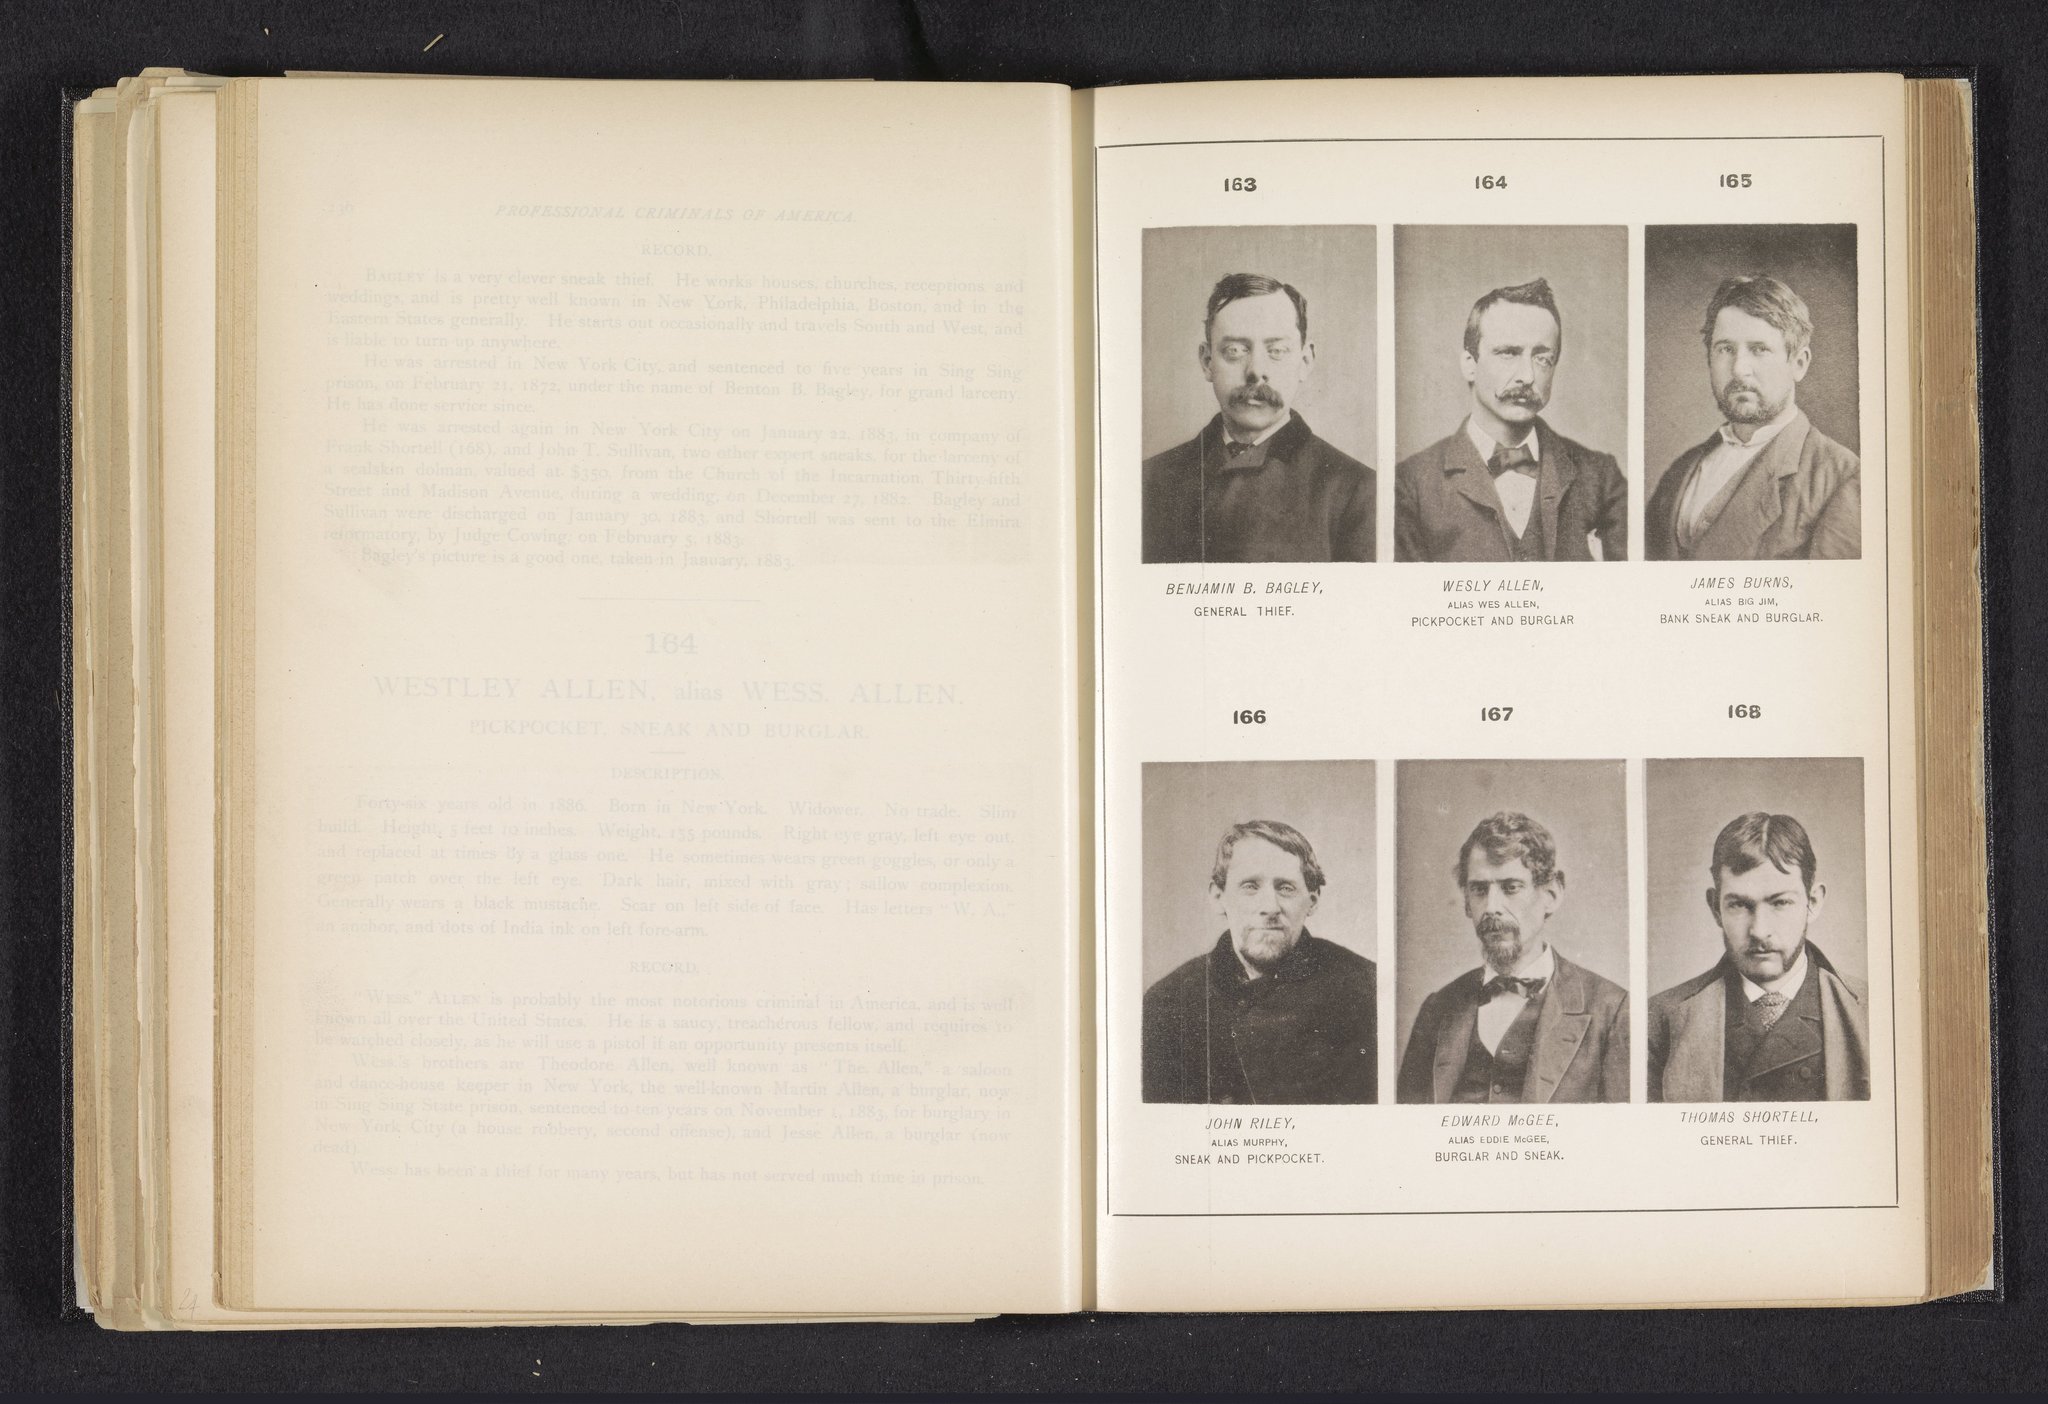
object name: page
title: Zes portretten van dieven en inbrekers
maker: Anonymous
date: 1881-1886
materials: paper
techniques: photograph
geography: boston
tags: historical persons not known by name (+ (full) bust portrait), burglar, housebreaker, thief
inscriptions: inscription: ‘Benjamin B. Bagley (...) general thief.’, number: ‘163 (...) 168’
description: Linksboven Benjamin B. Bagley, midden boven Wesly Allen, rechtsboven James Burns, linksonder John Riley, midden onder Edward McGee, rechtsonder Thomas Shortell.